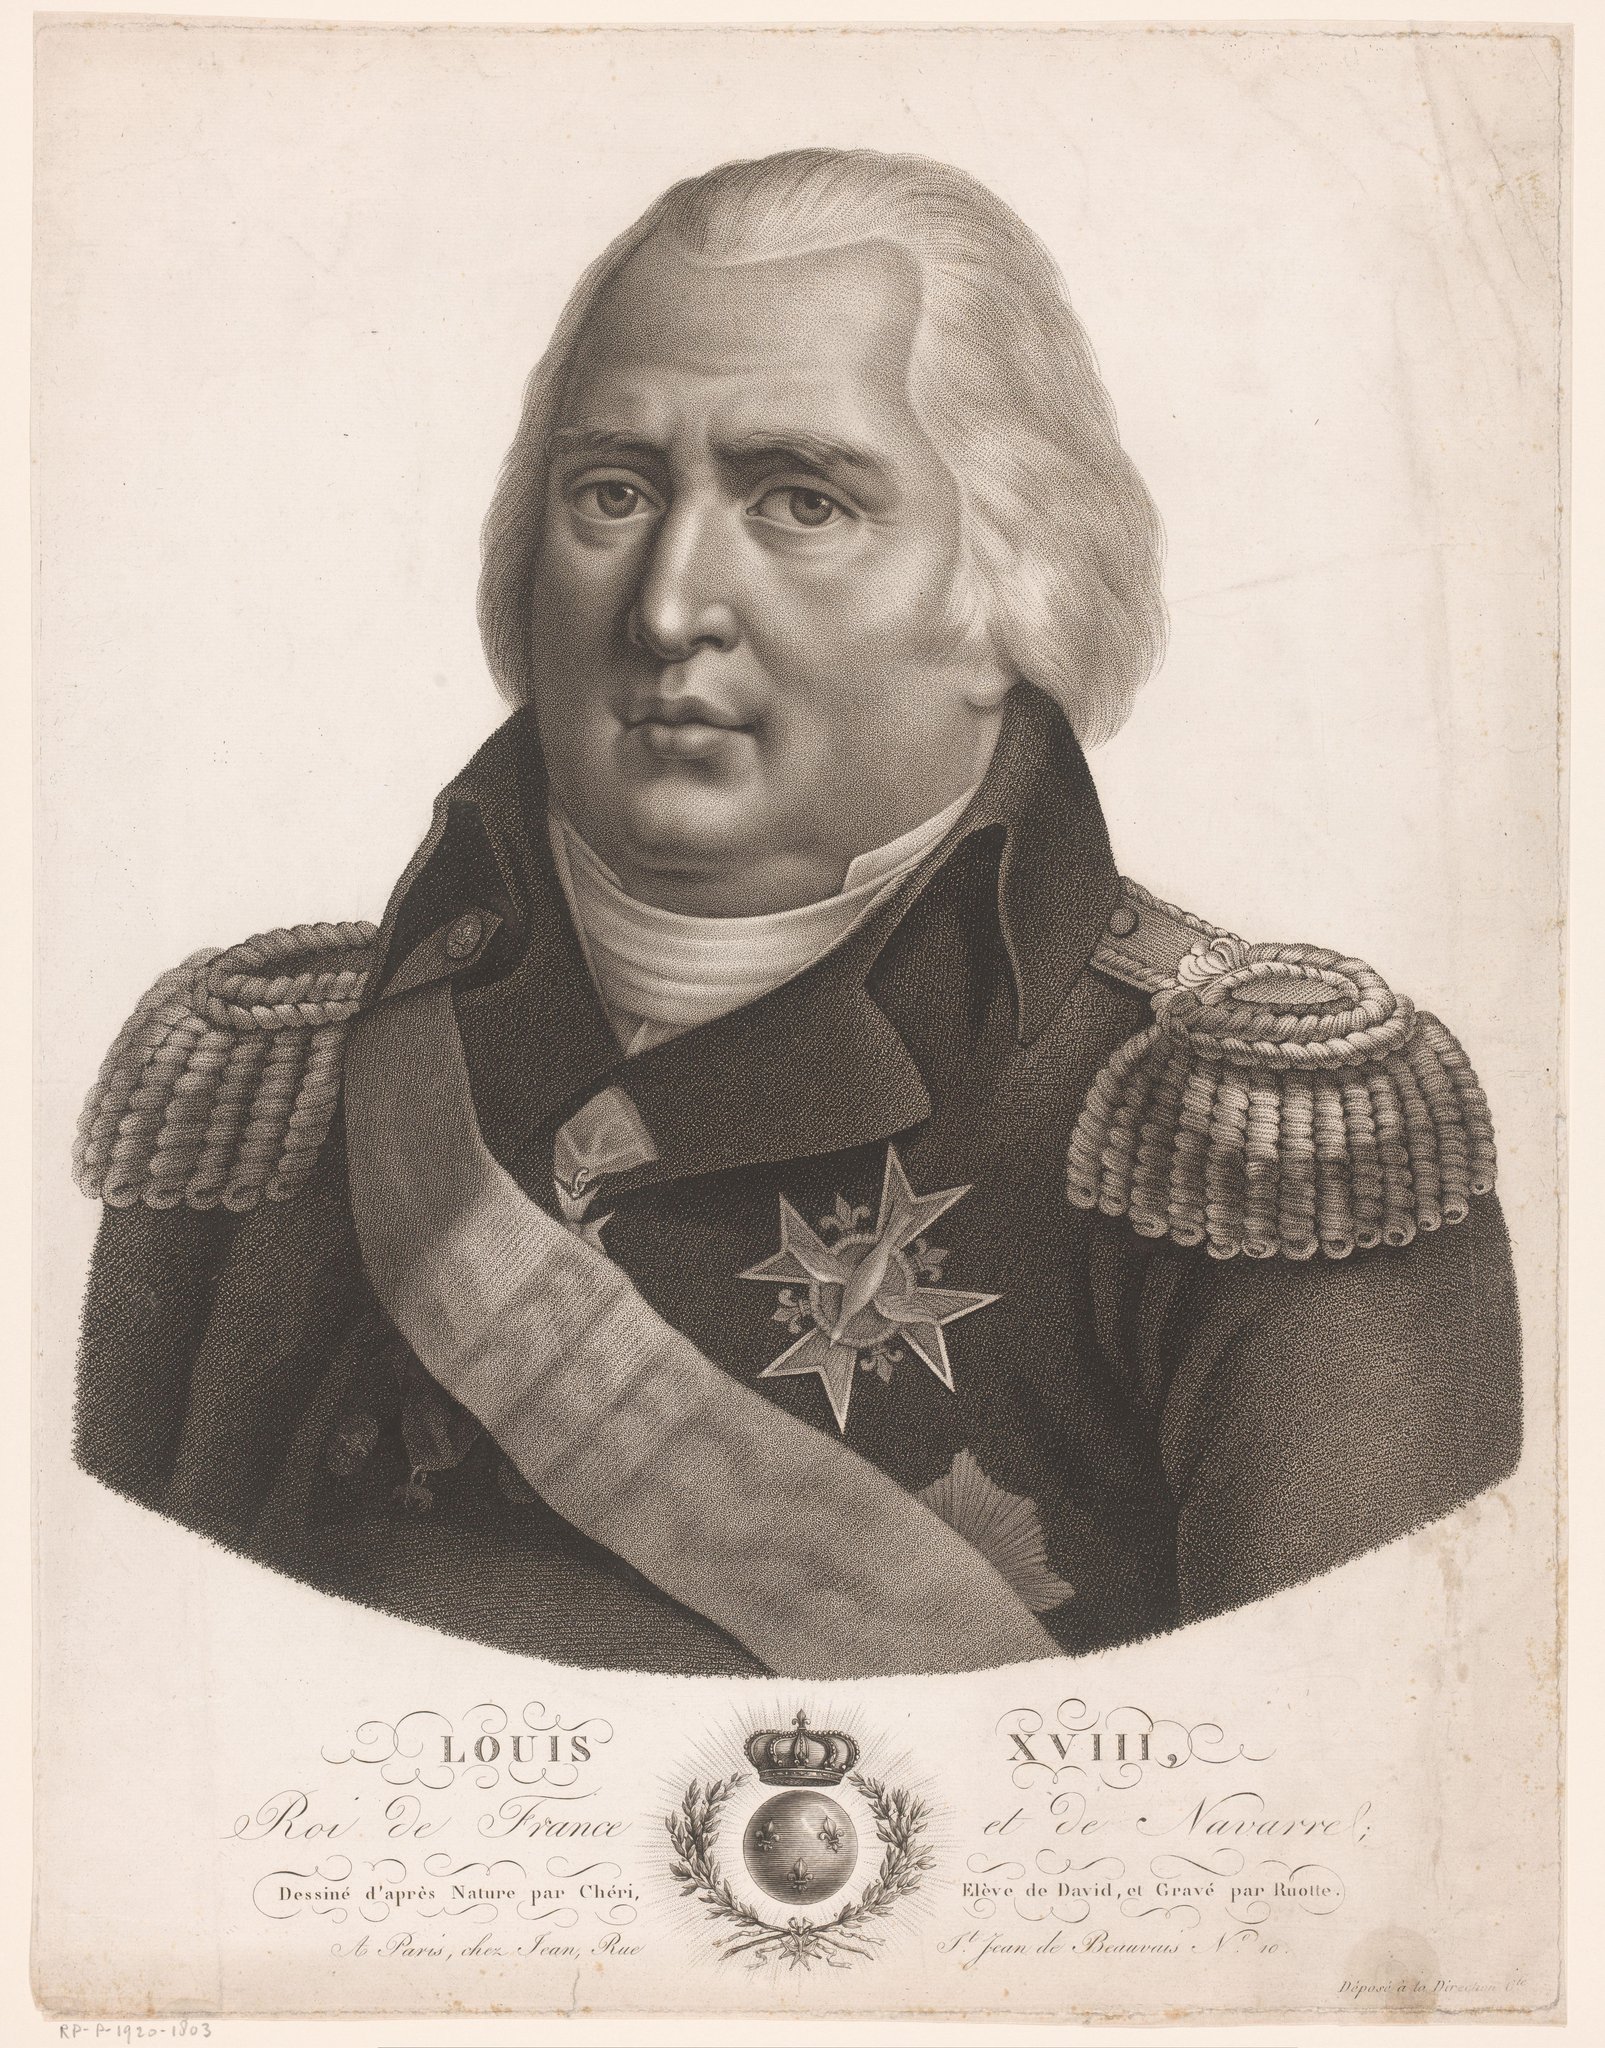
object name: print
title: Portret van Lodewijk XVIII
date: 1764-1806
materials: paper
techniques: etching, roulette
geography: paris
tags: paris, lodewijk xviii (koning van frankrijk), historical persons, king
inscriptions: collector's mark: Lugt 2228, : ‘Déposé à la Direction Gle’